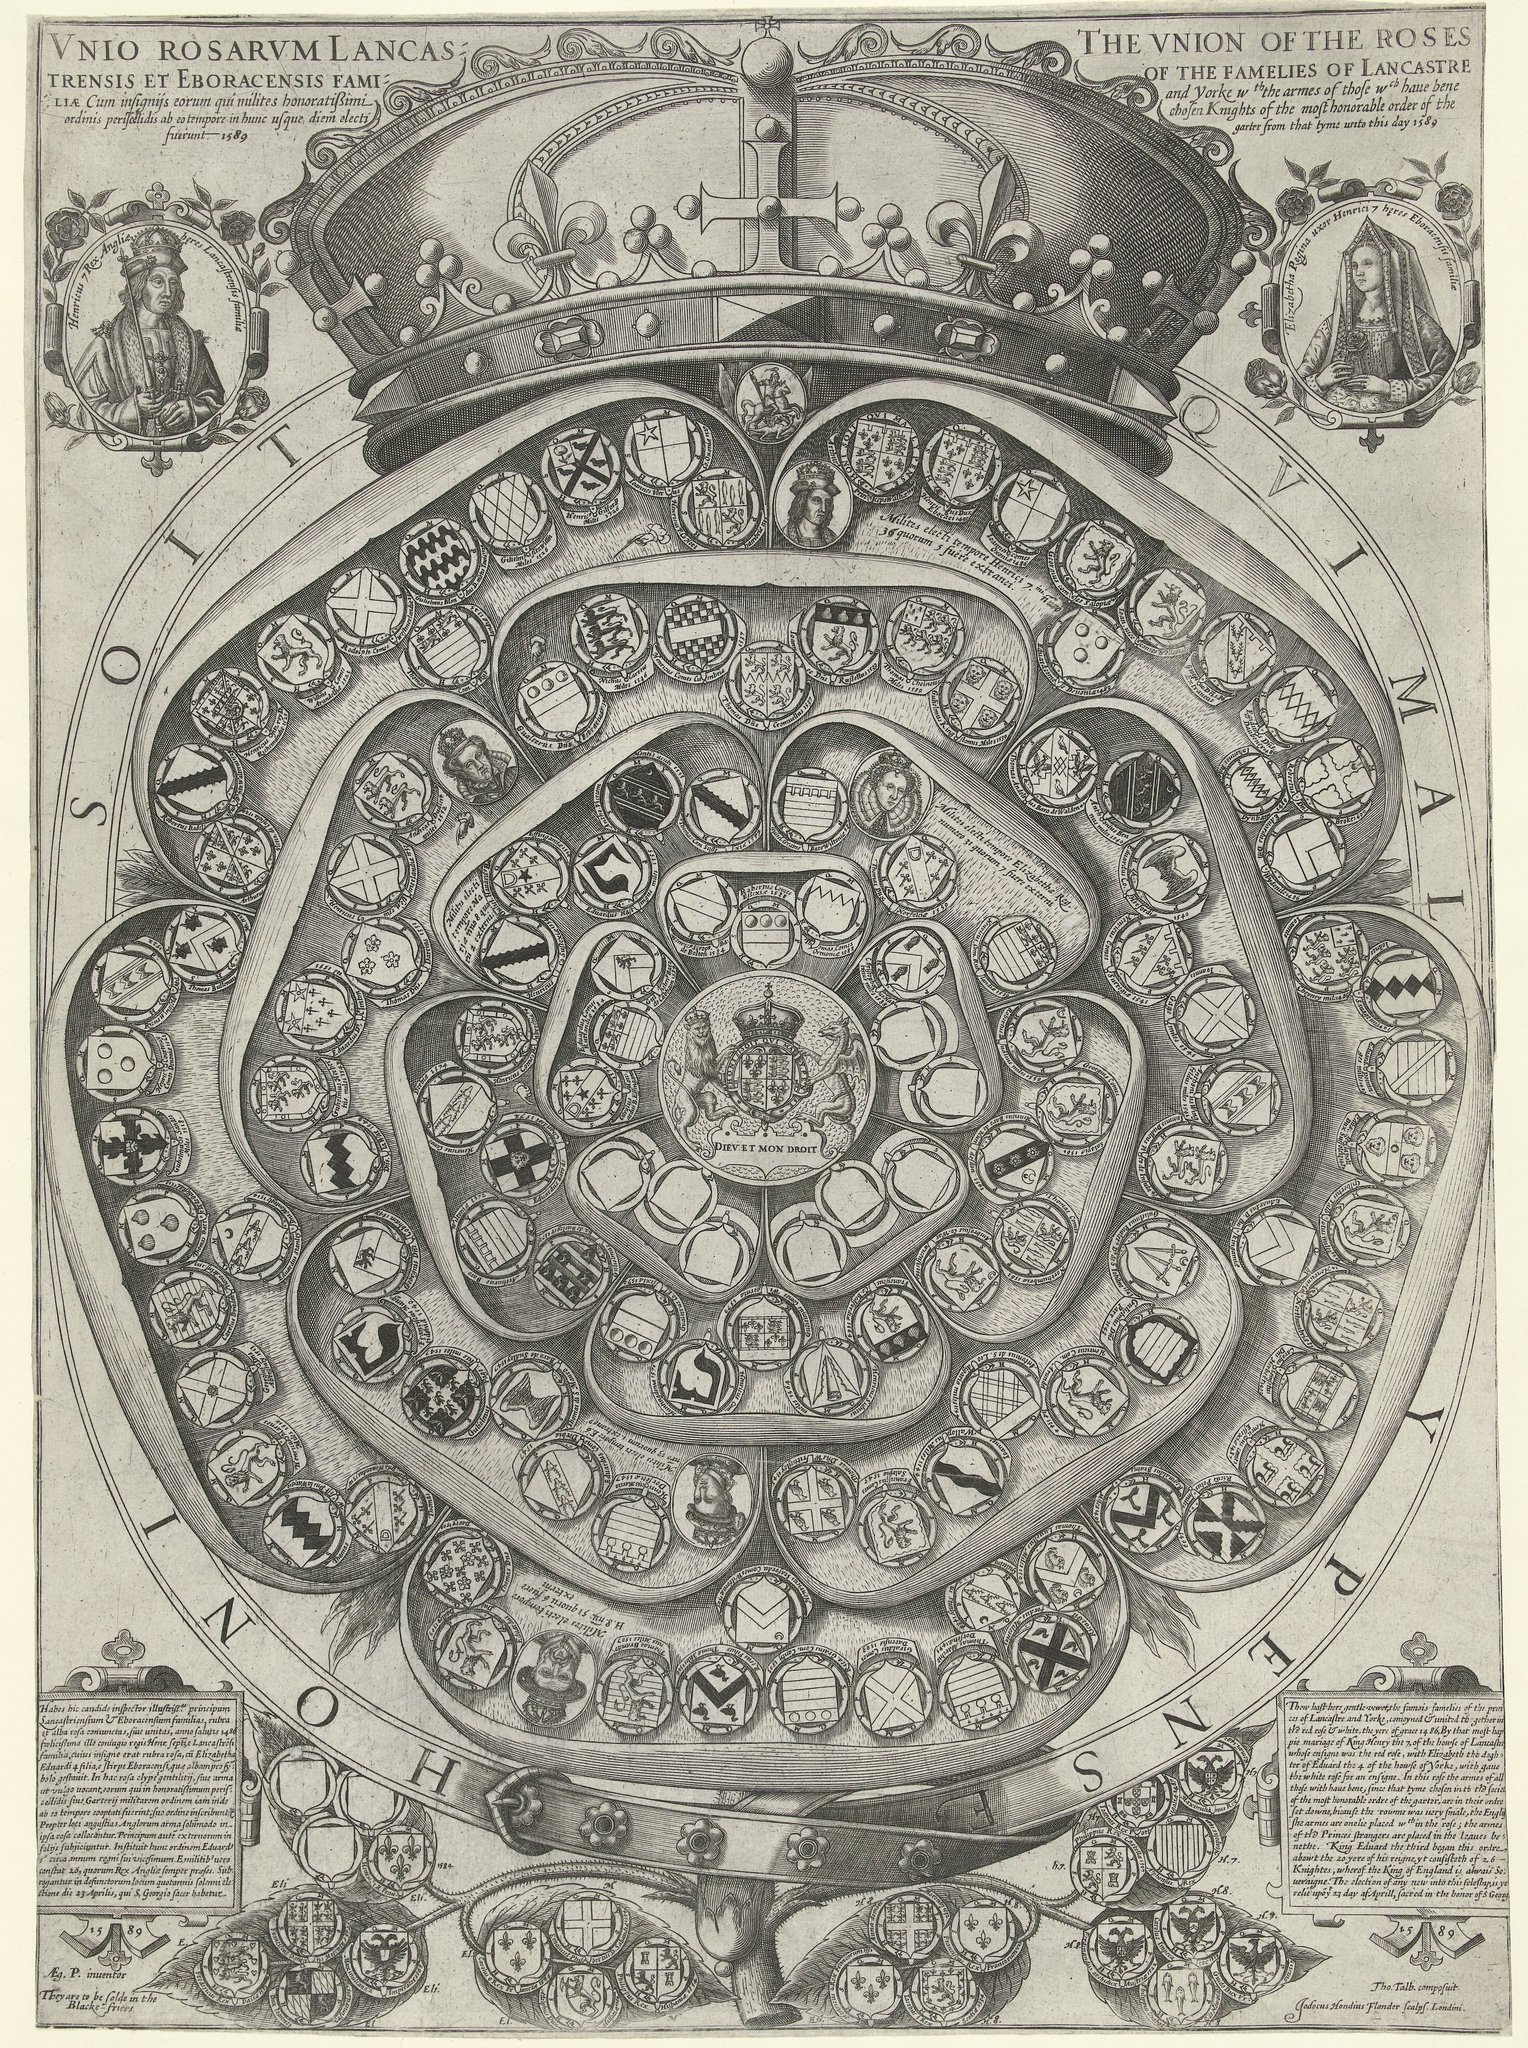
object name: print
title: Gekroonde Tudor Rose met wapens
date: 1589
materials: paper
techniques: engraving, etching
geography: london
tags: crown (symbol of sovereignty), armorial bearing, heraldry, england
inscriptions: collector's mark: Lugt 2228, collector's mark: Lugt 2760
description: Een gekroonde roos, als heraldisch embleem van Engeland, voorstellende het huis van Lancaster en het huis van York, samengevoegd door Henry VII. In het midden het wapenschild van Engeland met de spreuk: Diev et mon Droit. Daaromheen tal van wapens, omgeven door een ovaal met randschrift in het Latijn. Links- en rechtsonderaan twee cartouches met tekst; links in het Latijn en rechts in het Engels. Linksboven het portret van Henry VII en rechtsboven het portret van Elizabeth of York, beide in een met rozen omgeven ovaal.